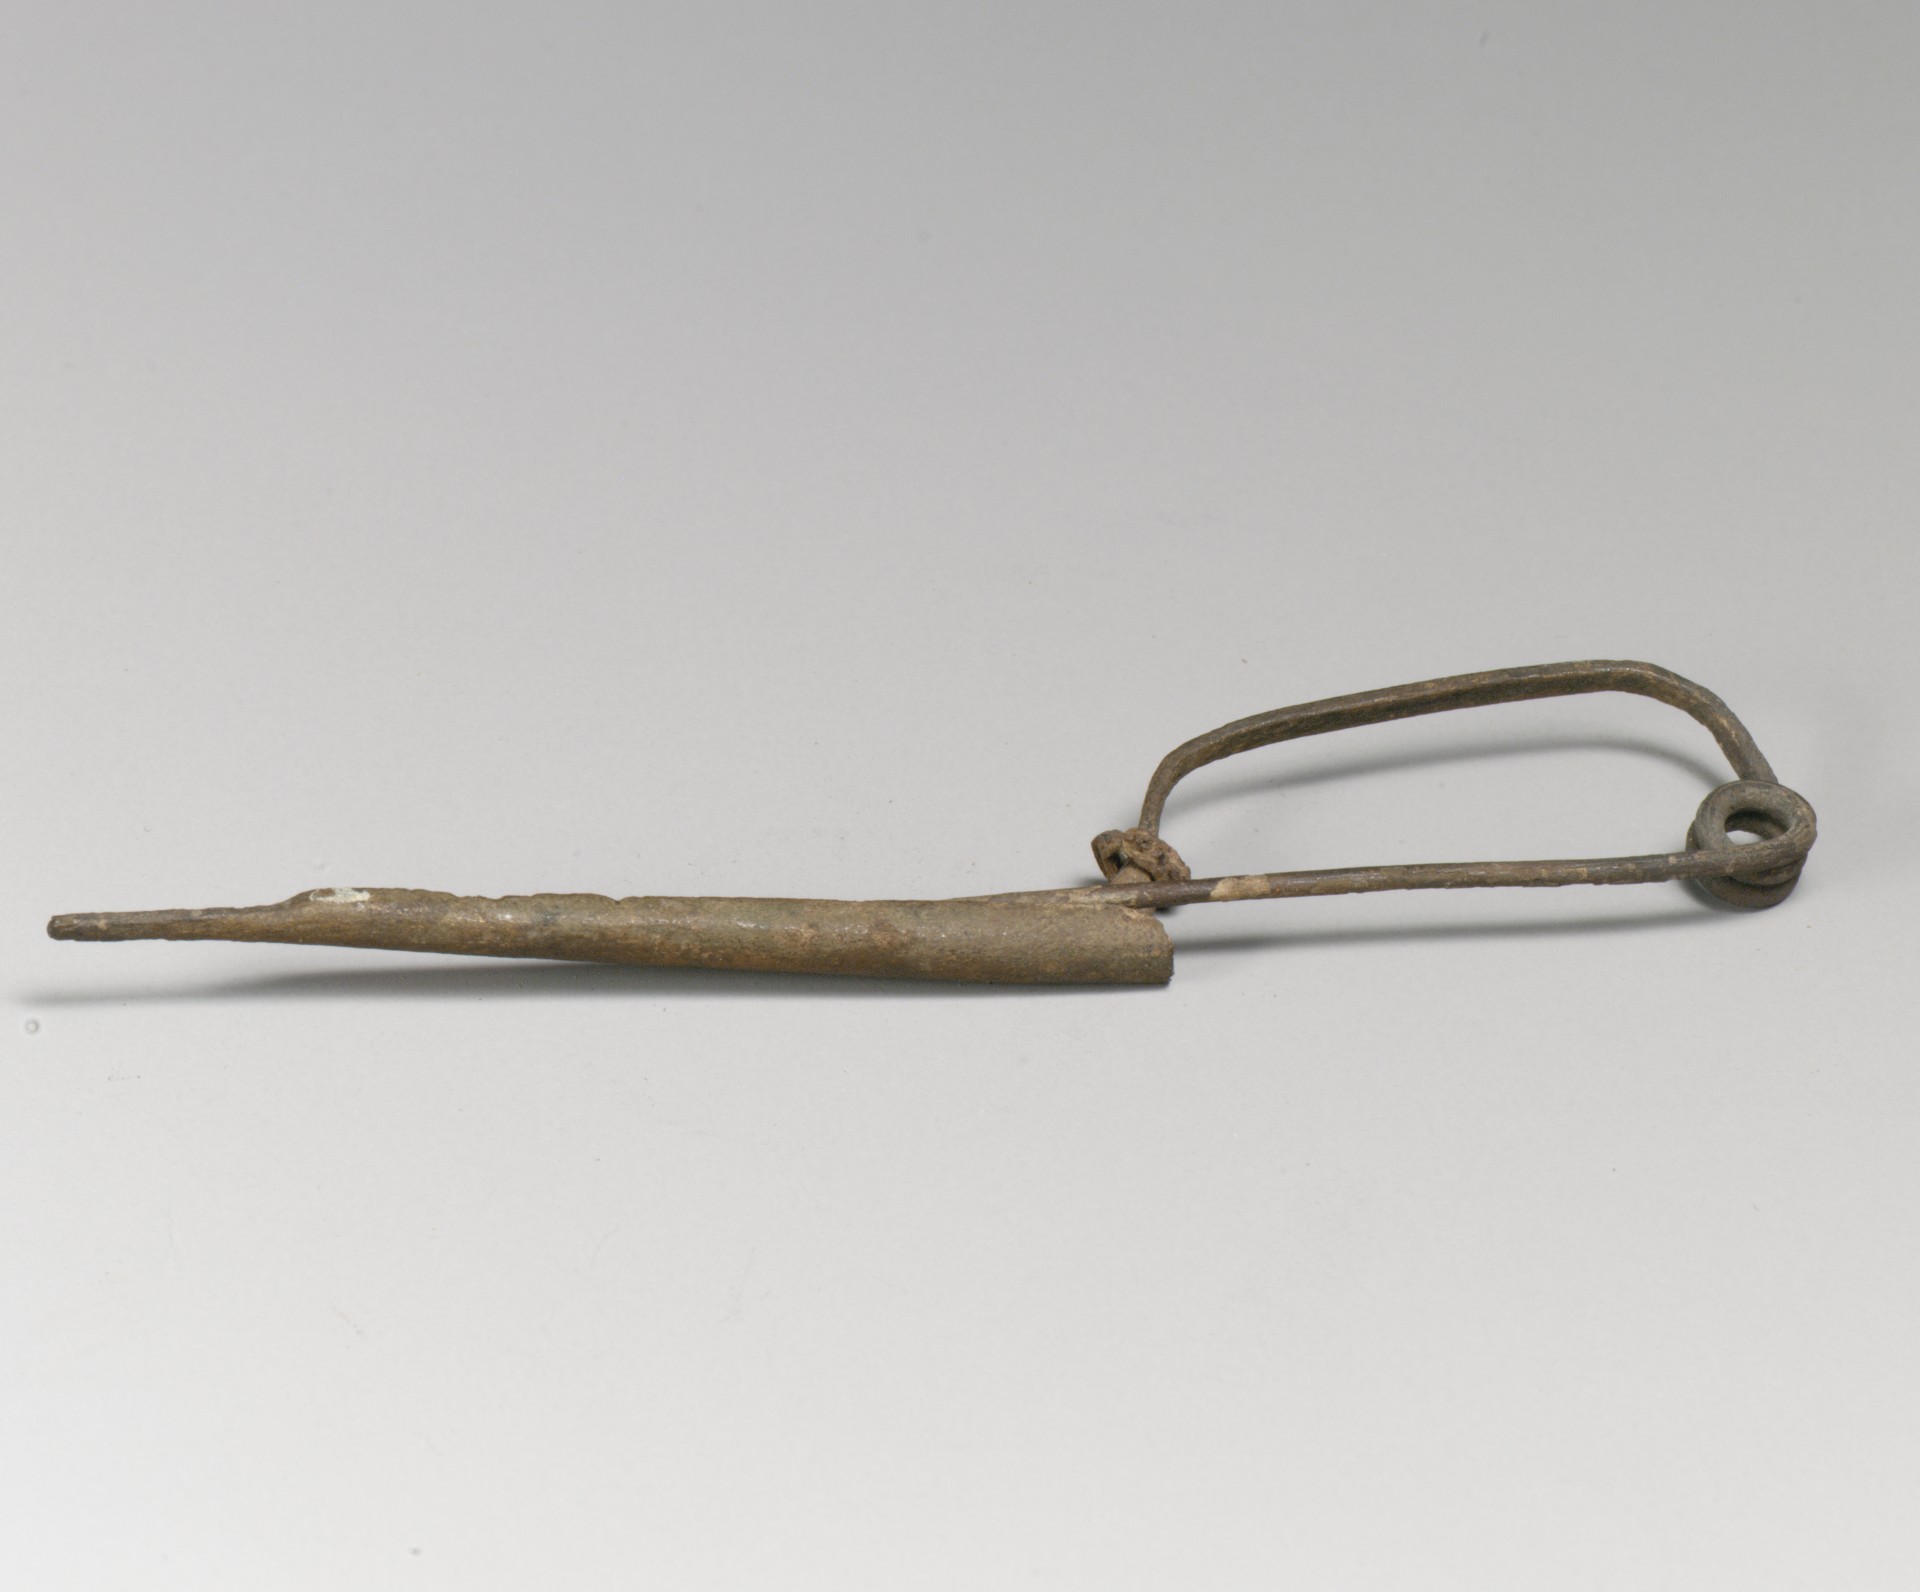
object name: fibula with silver bead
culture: italic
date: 700-501 BCE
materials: bronze, silver